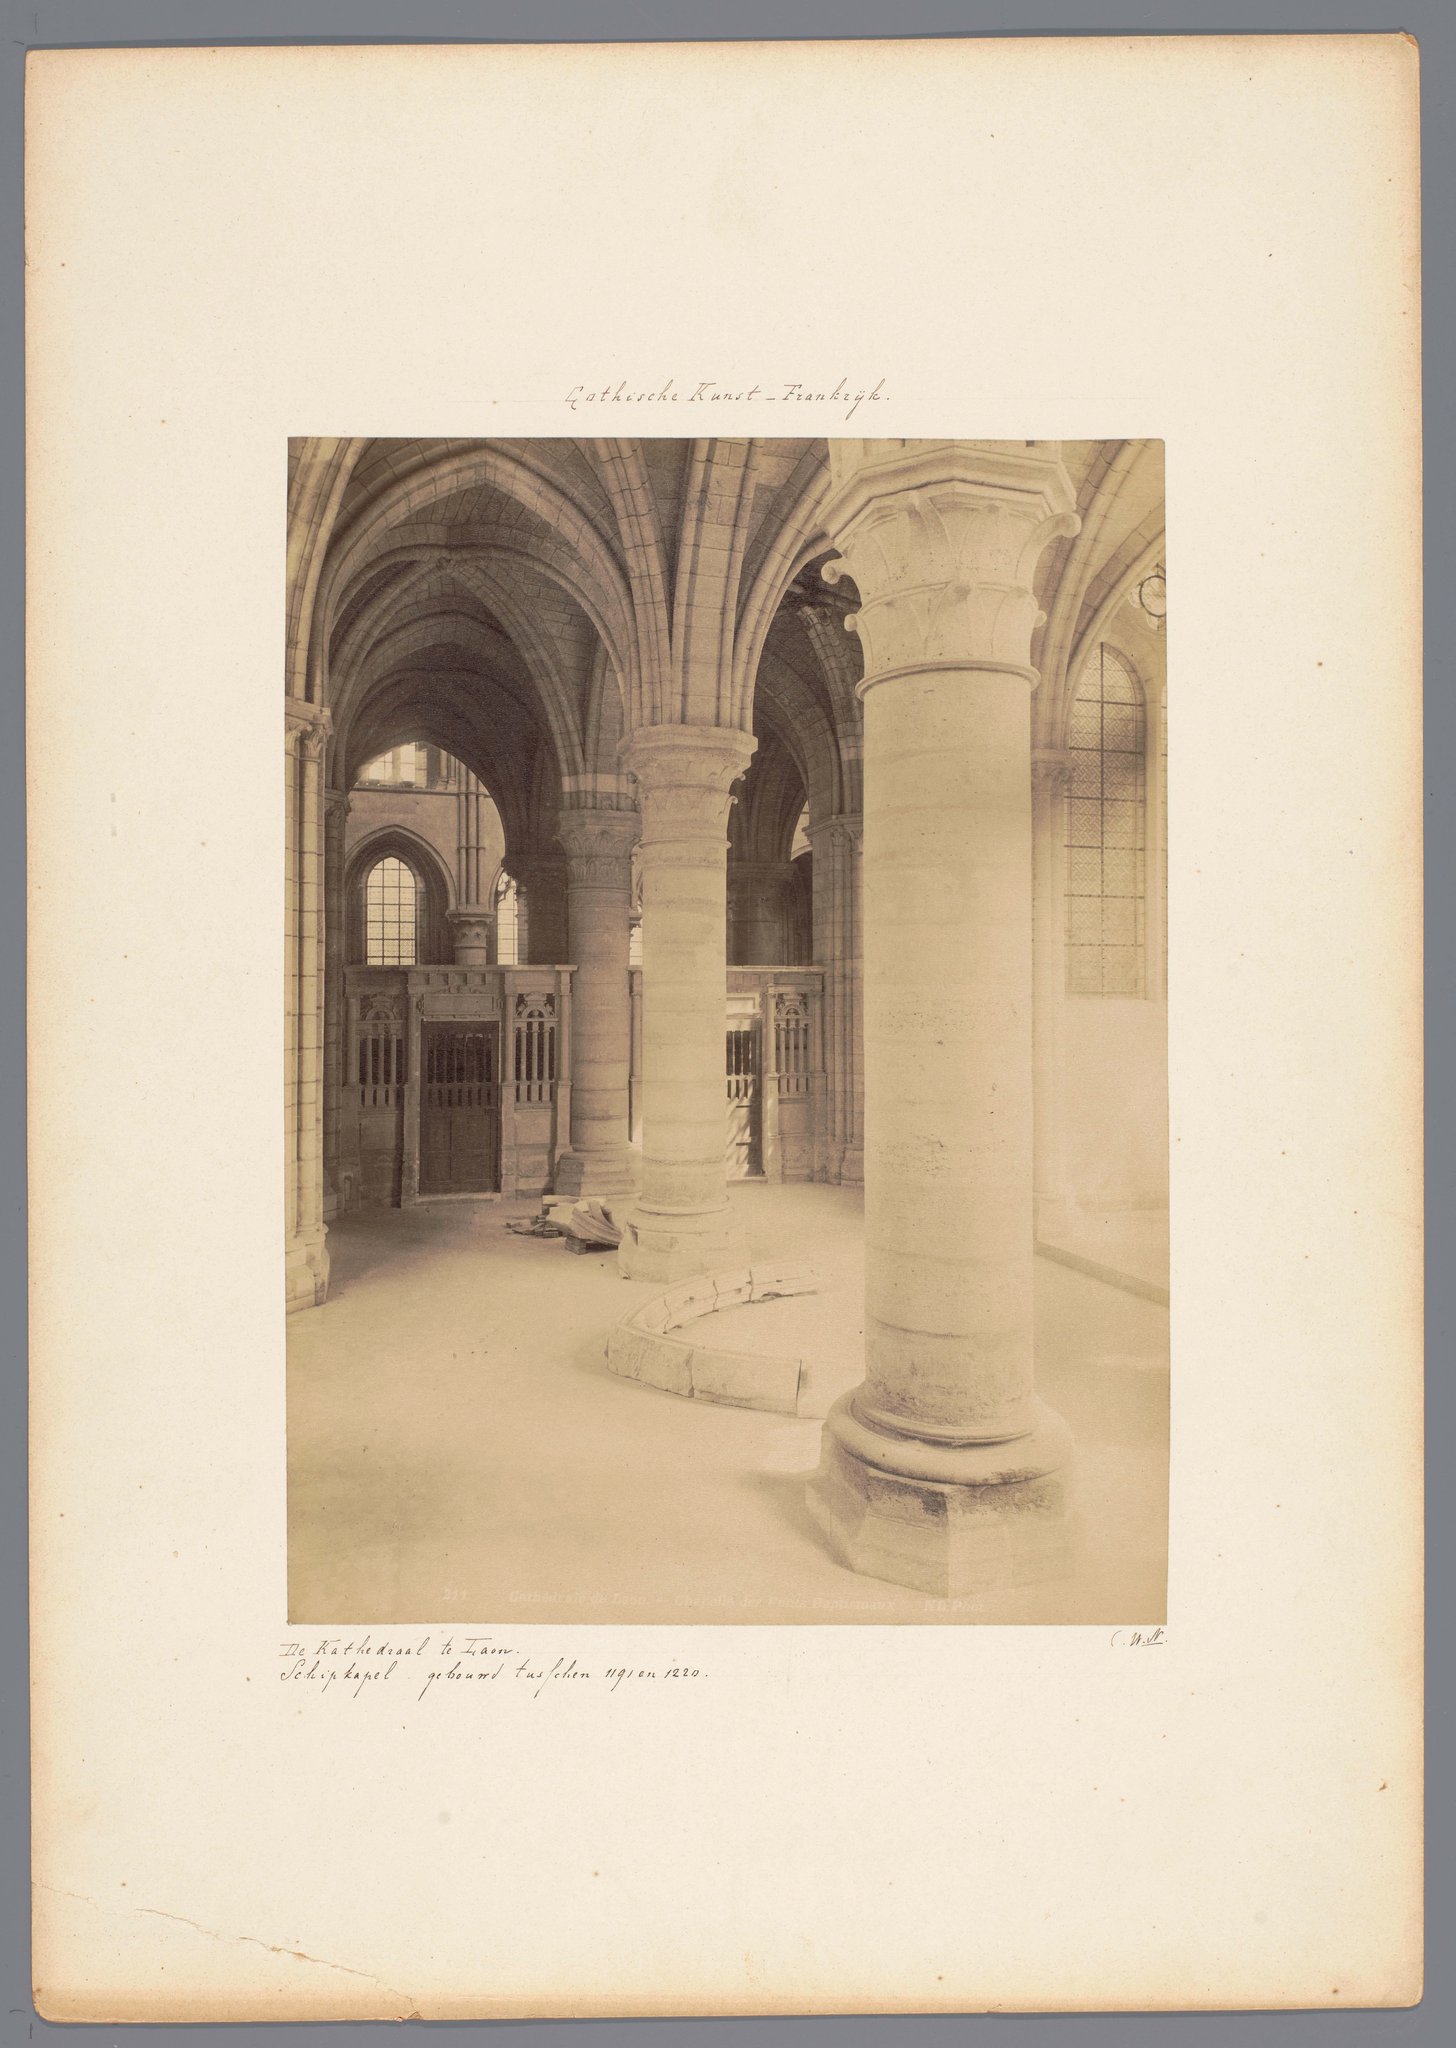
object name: photograph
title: Cathédrale de Laon. - Chapelle des Pents Baptismaux .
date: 1875-1900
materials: cardboard, photographic support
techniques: albumen print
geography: laon cathedral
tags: rood-screen, choir-screen; iconostasis, column, pillar ~ architecture, parts of church interior: chapel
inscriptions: inscription: ‘Gothische Kunst - Frankrijk. De Kathedraal te Laon. Schipkapel , gebouwd tussen 1191 en 1220.’, number: ‘211’, collector's mark: ‘KUNSTNIJVERHEIDSCHOOL QUELLINUS AMSTERDAM FRANS HALSSTRAAT 14.’, collector's mark: ‘INSTITUUT VOOR KUNST- NIJVERHEIDSONDERWIJS GABRIËL METSUSTRAAT No. 16. AMSTERDAM’, inscription: ‘CWN.’